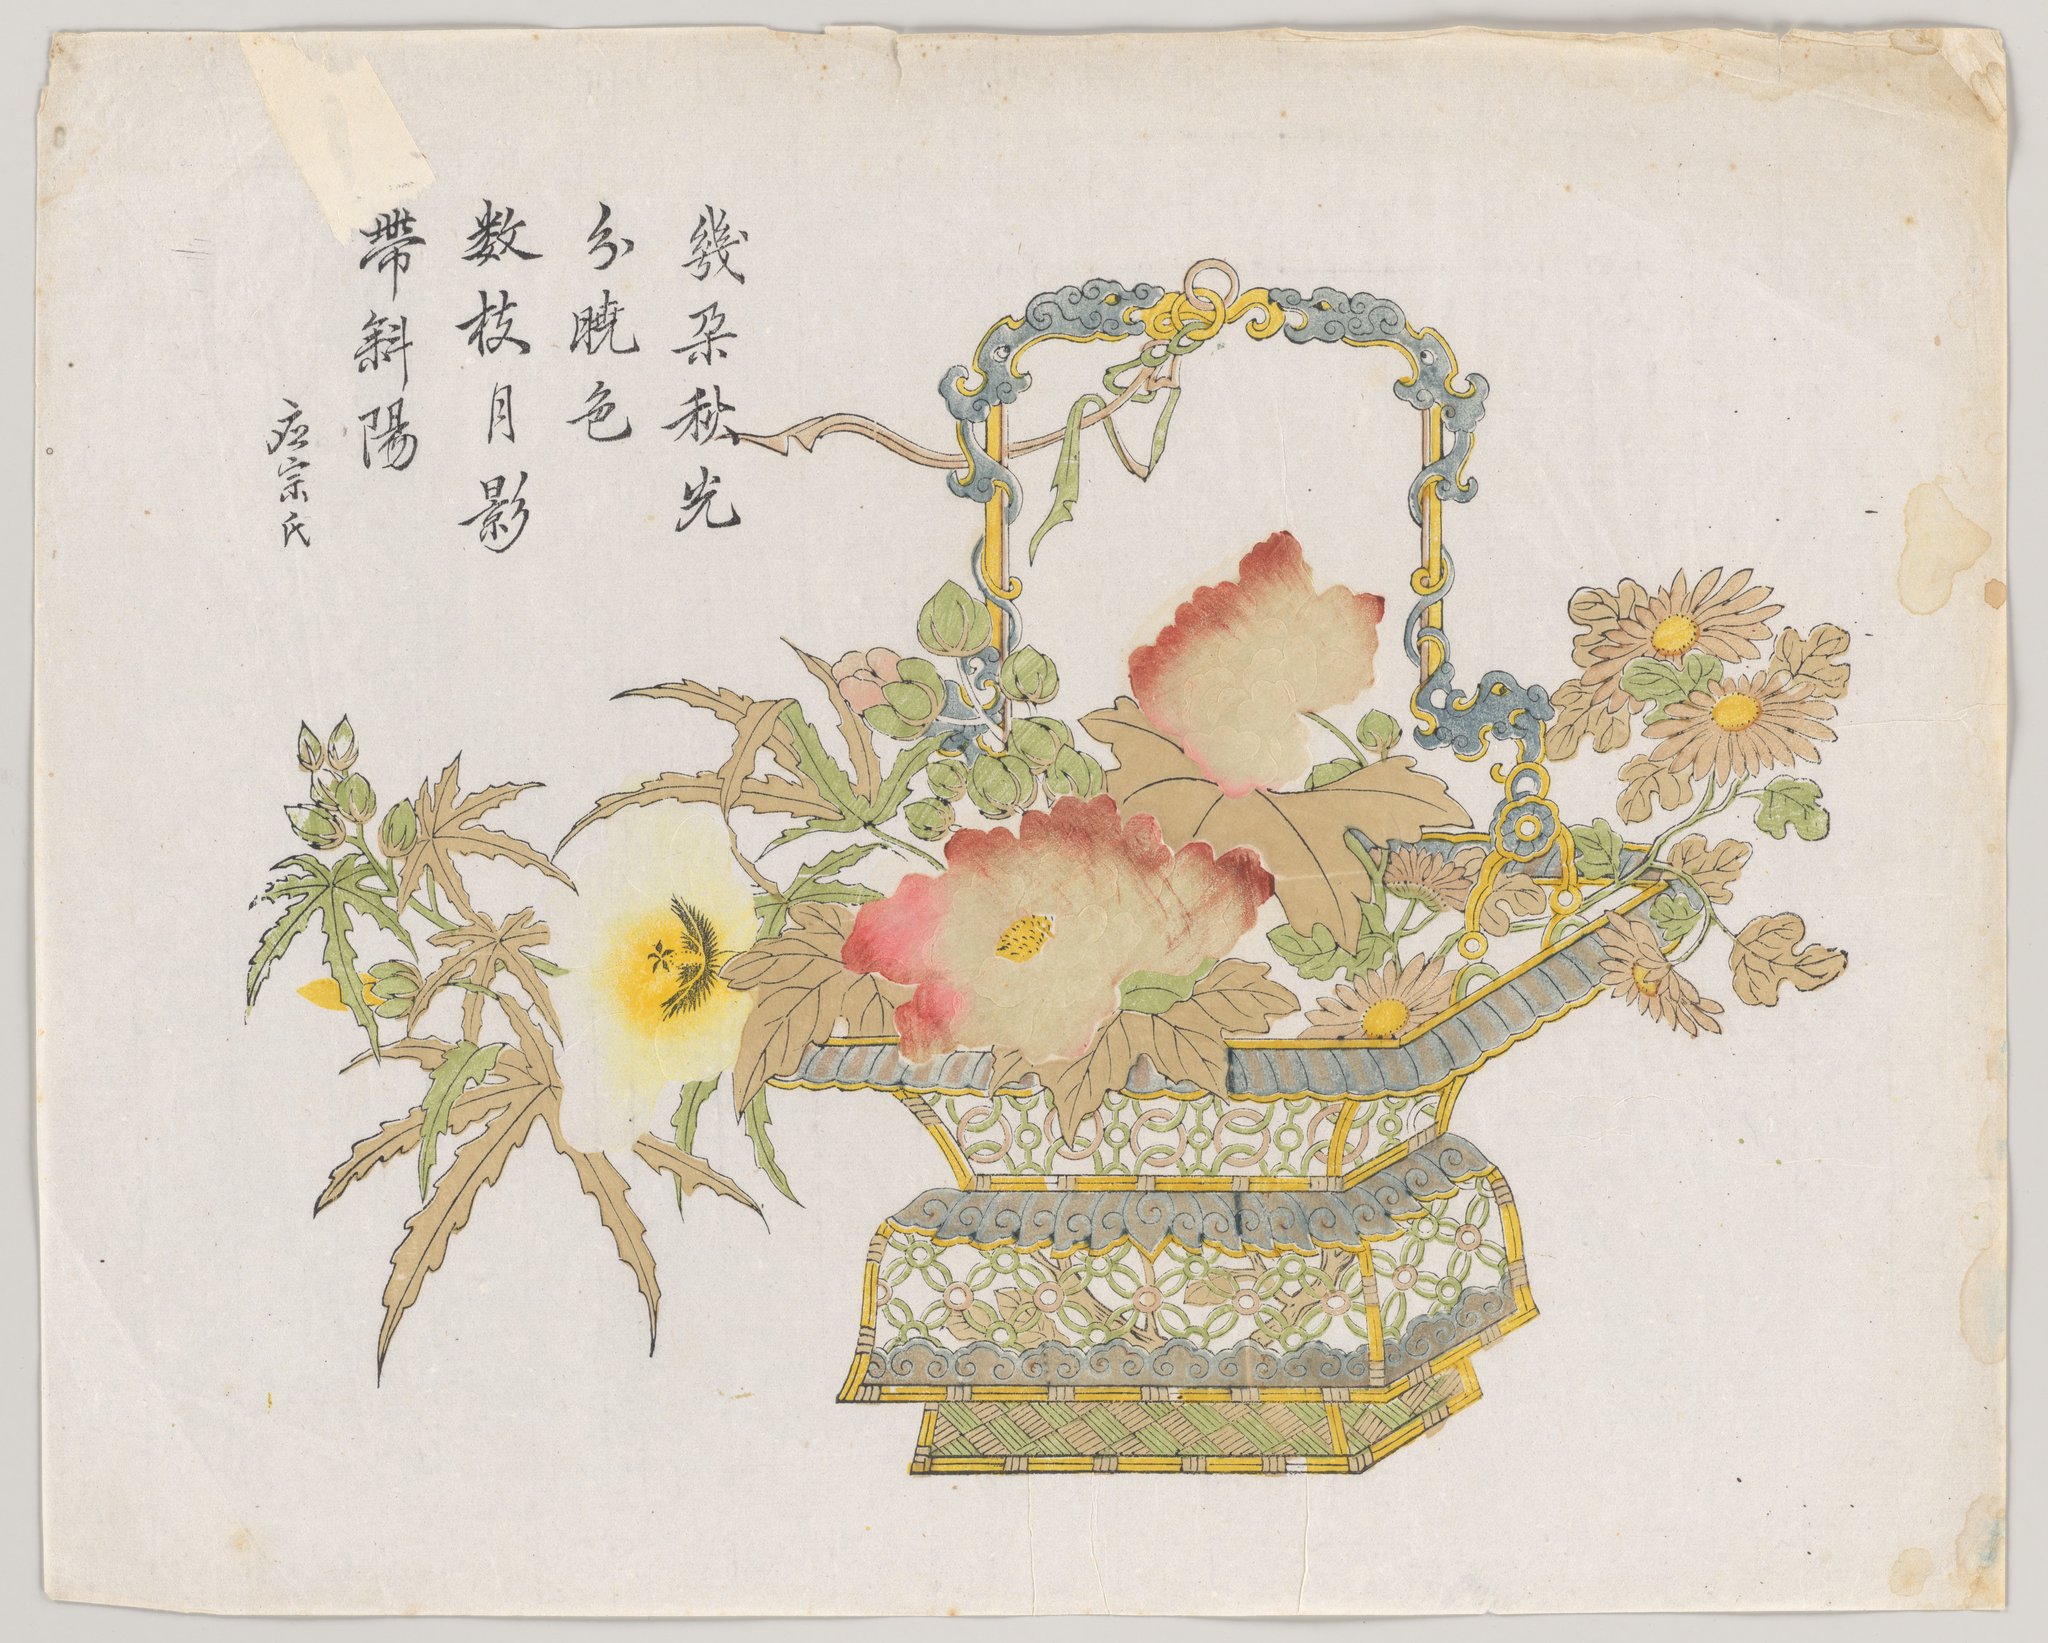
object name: print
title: Autumn basket: hibiscus, yellow hibiscus and chrysanthemum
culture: chinese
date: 1701-1800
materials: ink, paper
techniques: polychrome, woodblock print